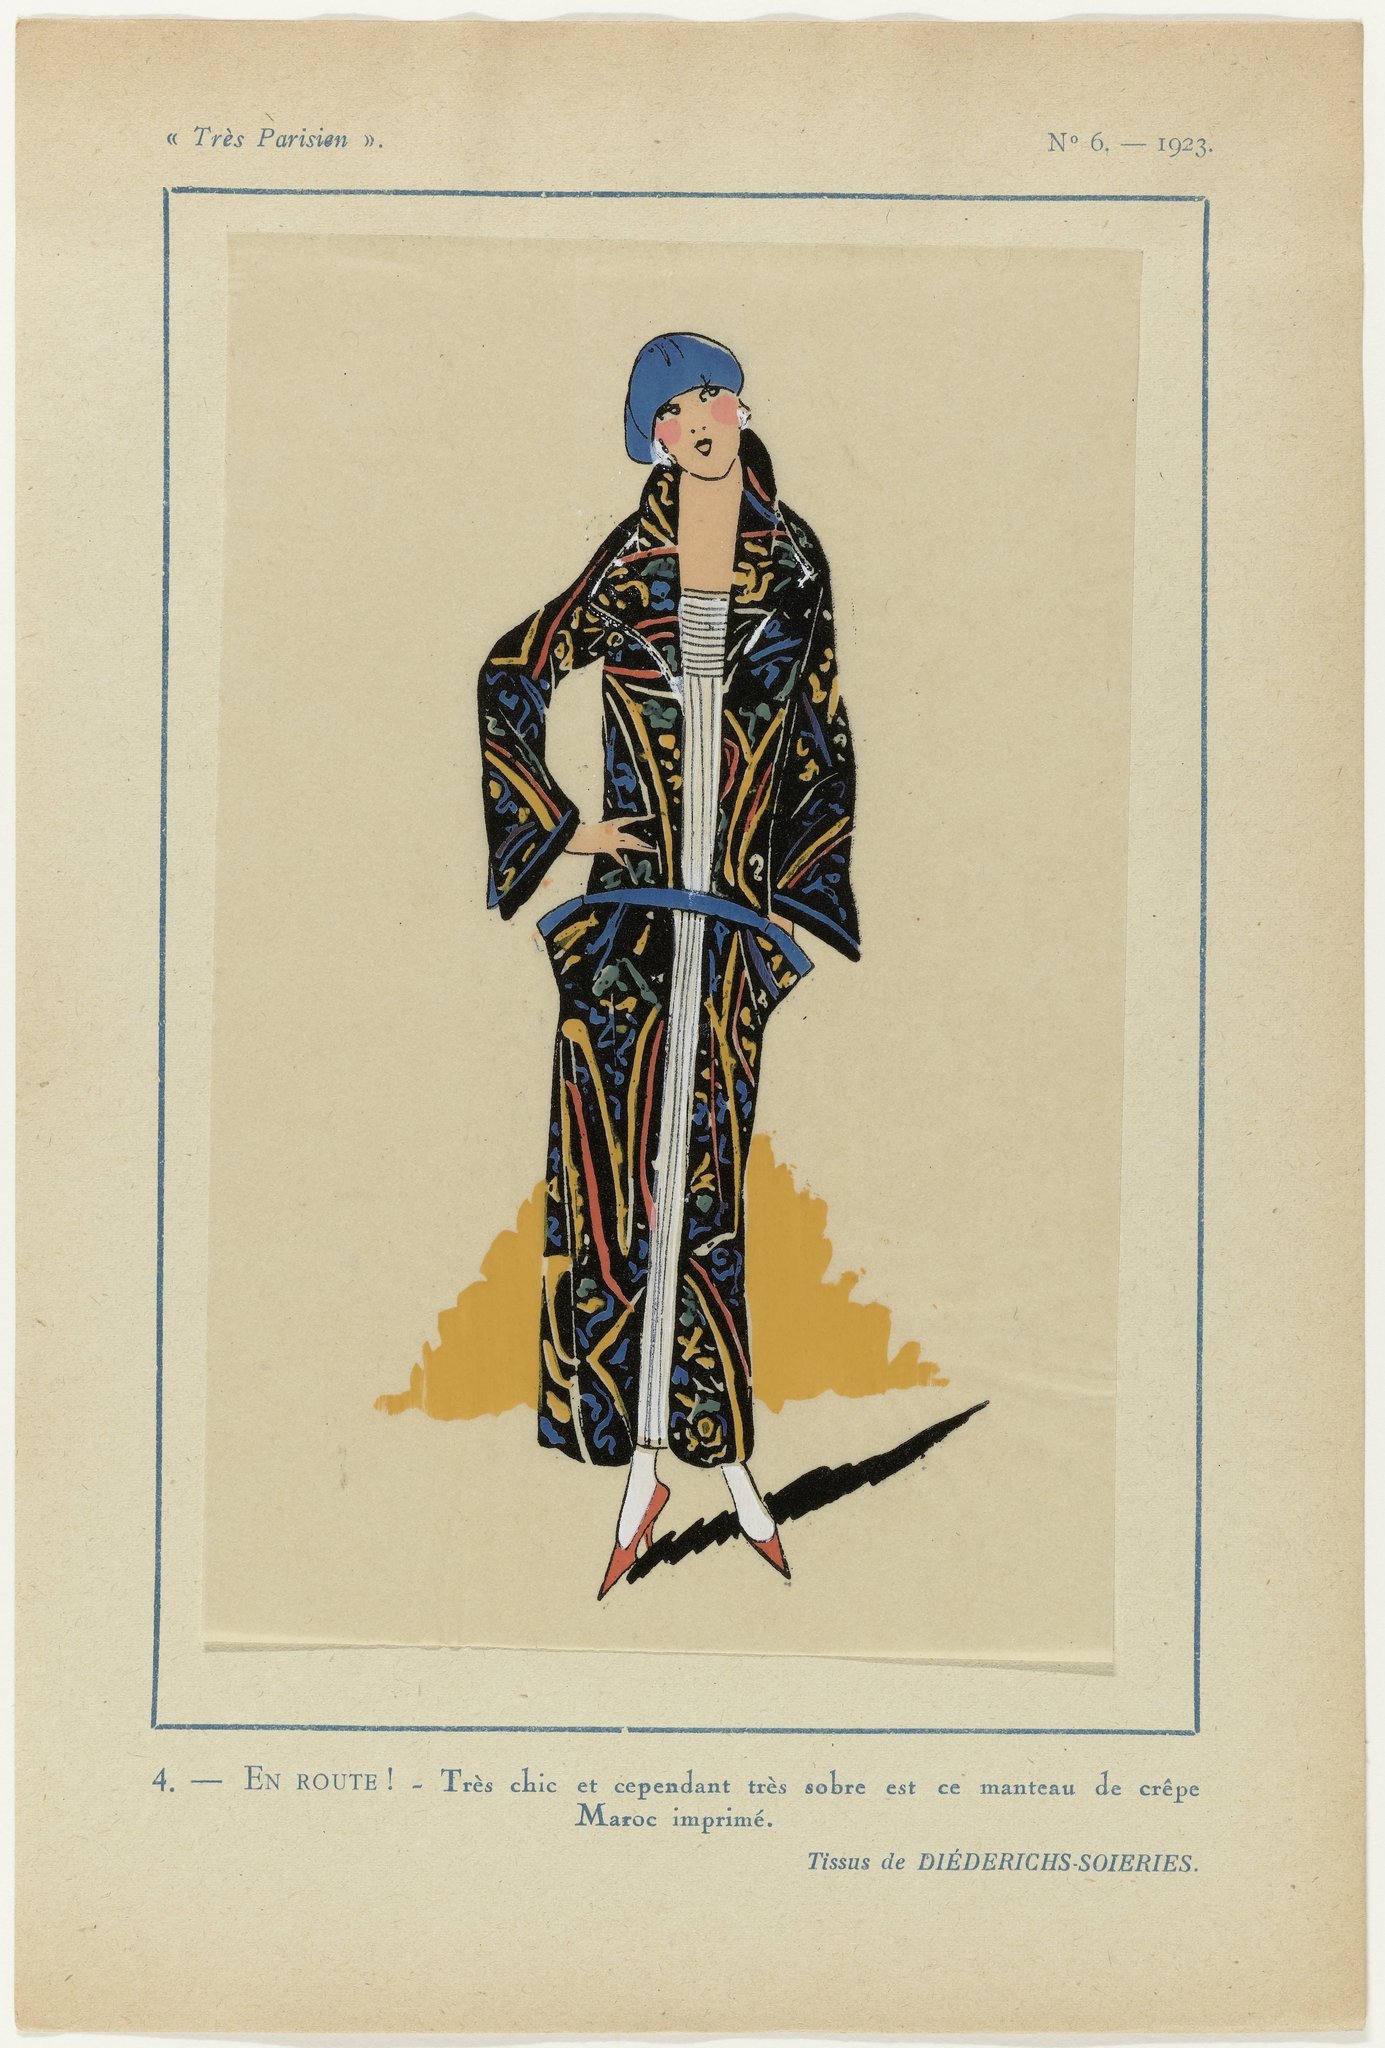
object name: fashion print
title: Très Parisien, 1923, No 6: 4.- EN ROUTE ! - Très chic....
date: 1923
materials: paper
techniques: hand coloring, letterpress printing, lithography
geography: paris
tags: head-gear: beret (+ women's clothes), coat (+ women's clothes), fashion plates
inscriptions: title: ‘Très Parisien / No 6. - 1923’, caption: ‘4. - EN ROUTE! - Très chic et cependant très sobre est ce manteau de crêpe Maroc imprimé. / Tissus de DIÉDERICHS-SOIERIES.’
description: Mantel van bedrukte crêpe Maroc. Stoffen van Diéderichs- Soieries. Accessoires: baret, pumps. Prent uit het modetijdschrift Très Parisien (1920-1936).